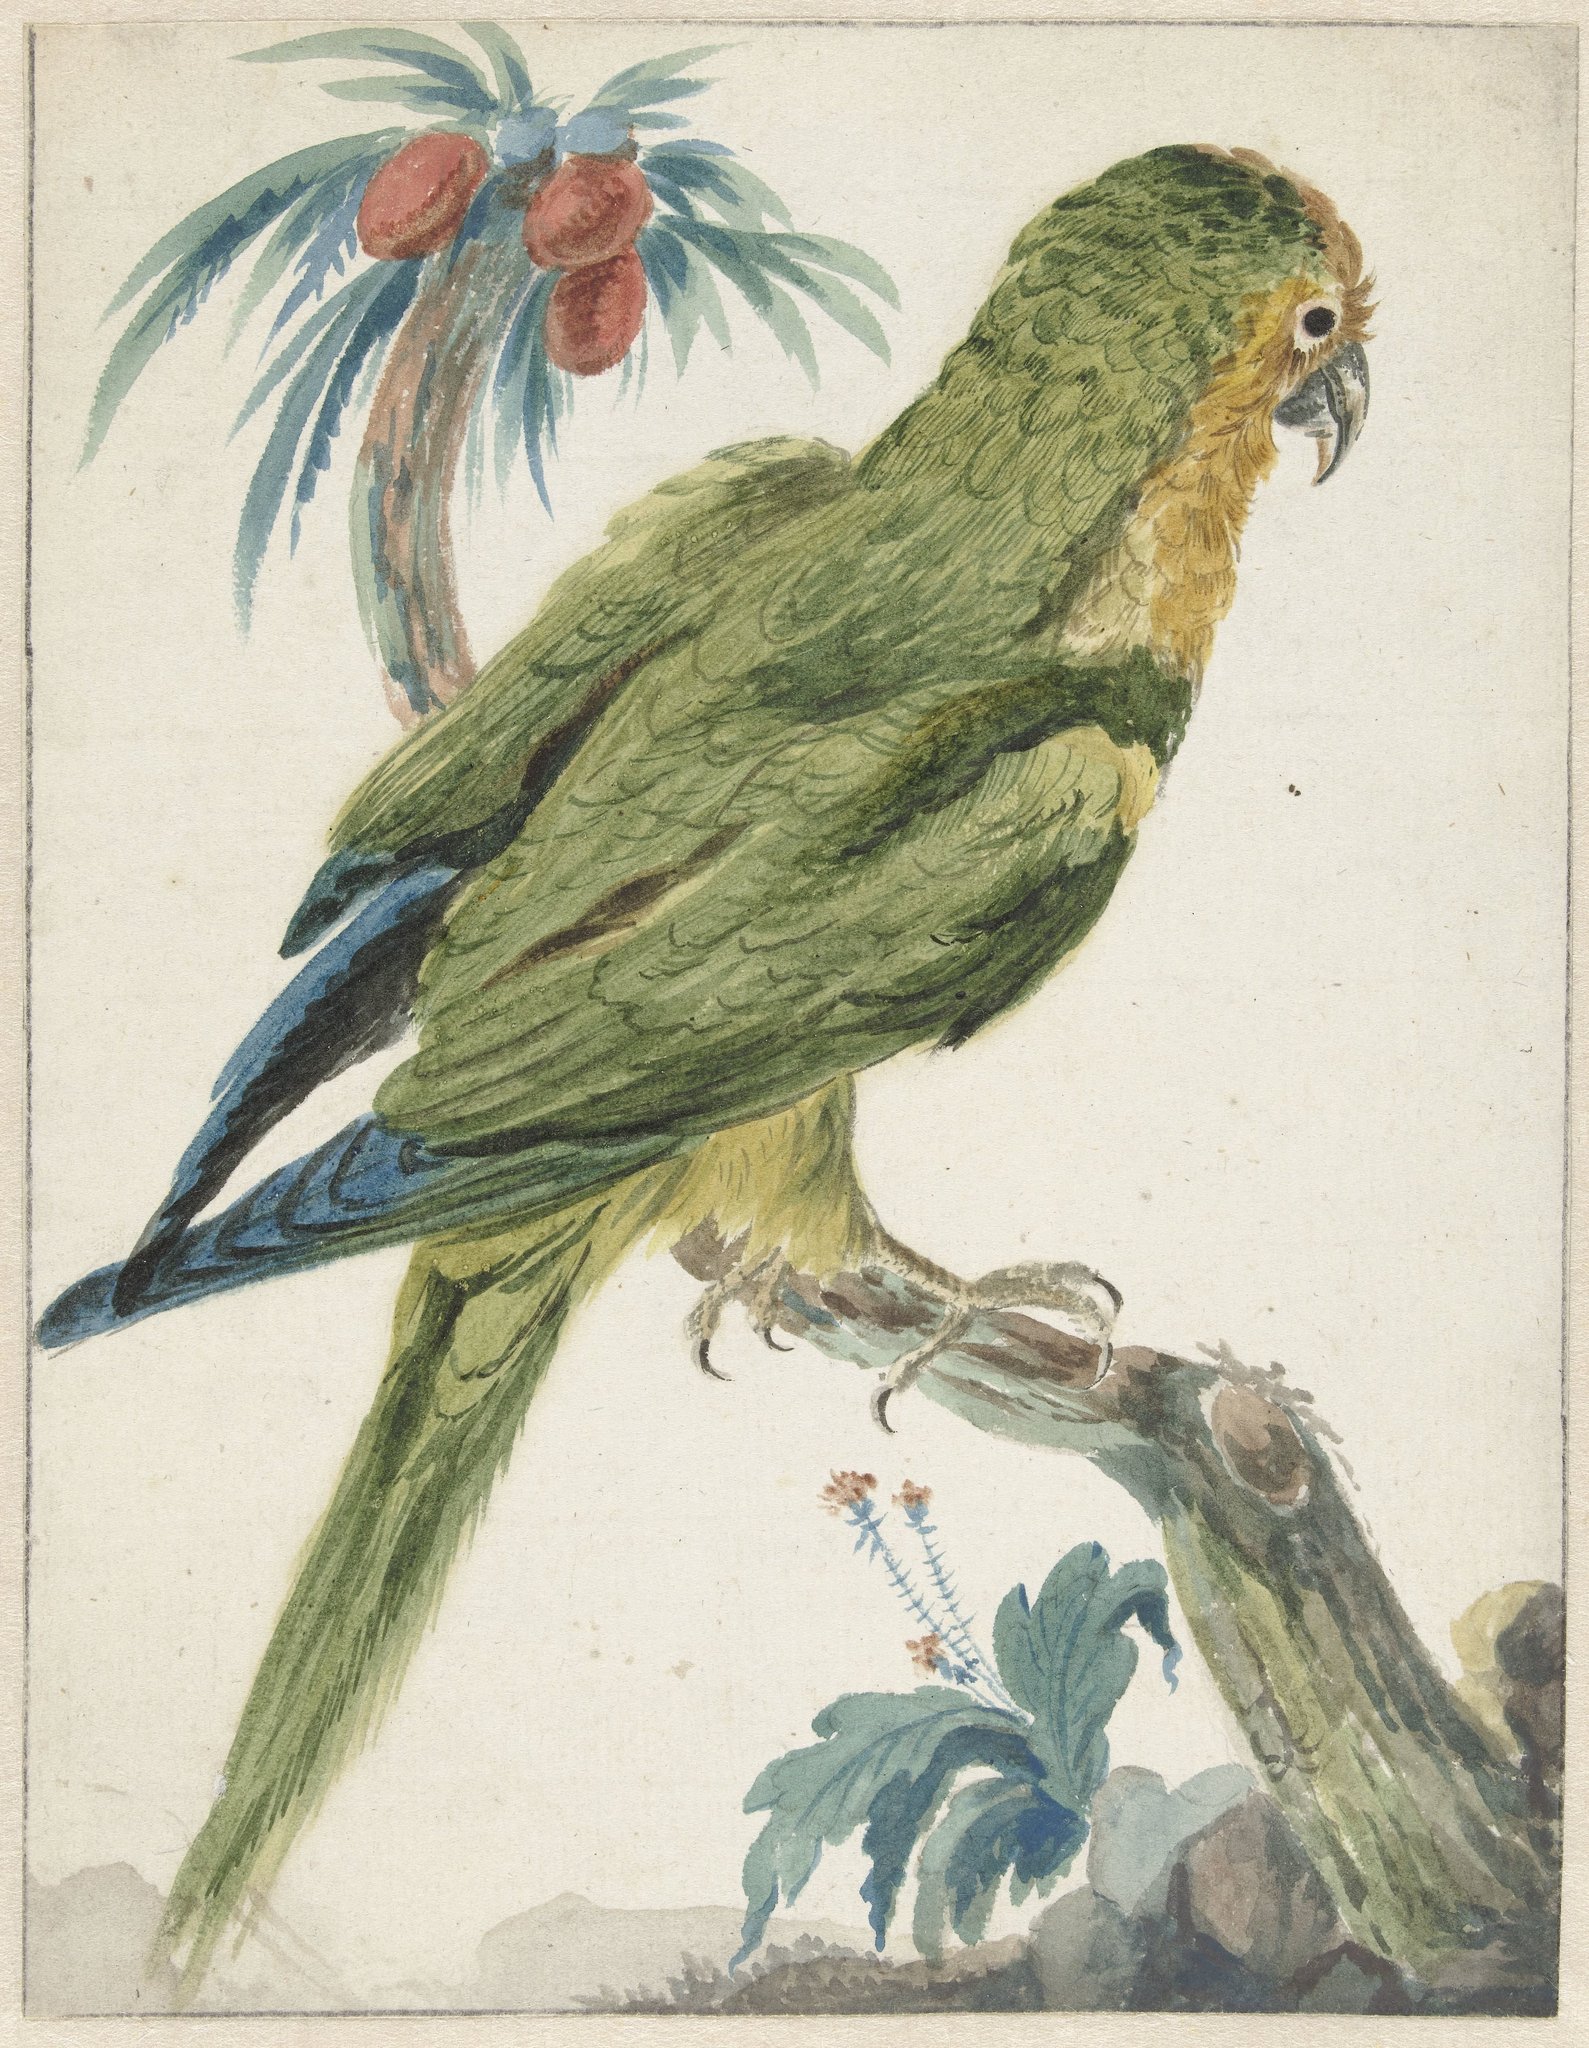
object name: drawing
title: Geelvoorhoofd parkiet (Bolborhyuchus aurifrons)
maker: jan weenix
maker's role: draughtsman, painter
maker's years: 1640-1719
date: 1650-1719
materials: paper, watercolor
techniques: brush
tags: ornamental birds: parakeet